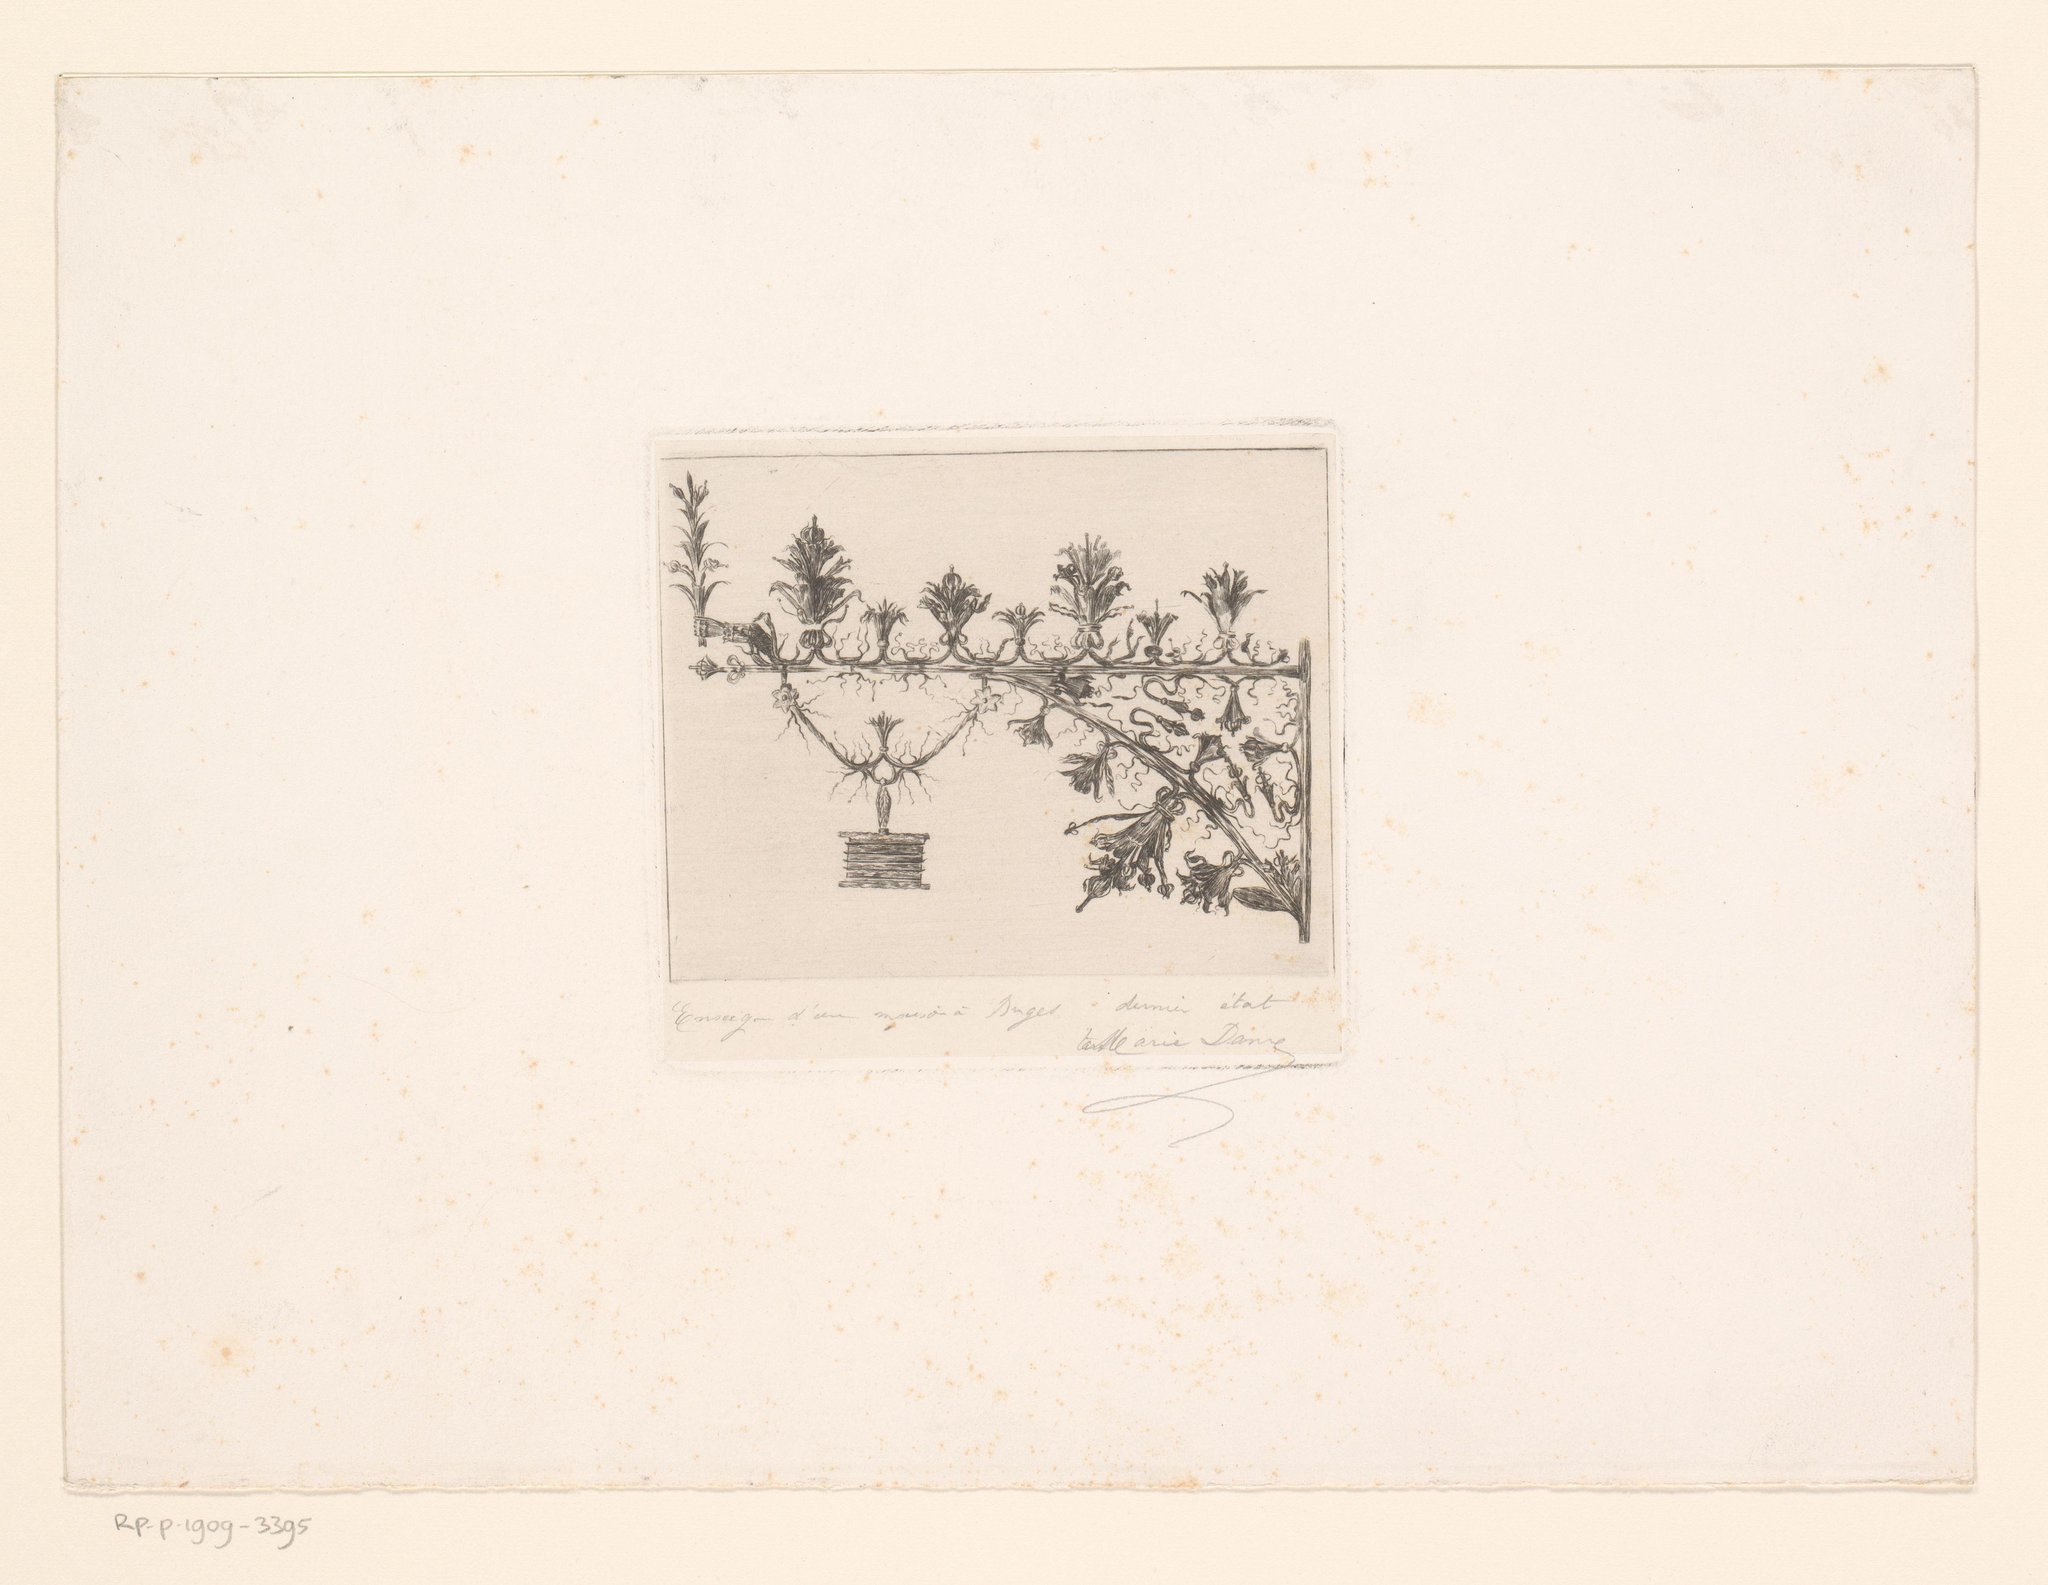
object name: print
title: Uithangbord te Brugge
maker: marie danse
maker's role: print maker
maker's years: 1867-1942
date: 1877-1909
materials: paper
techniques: etching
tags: signboard, bruges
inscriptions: collector's mark: Lugt 2228, inscription: ‘Enseign d'un maison à Bruges; Dernier état’